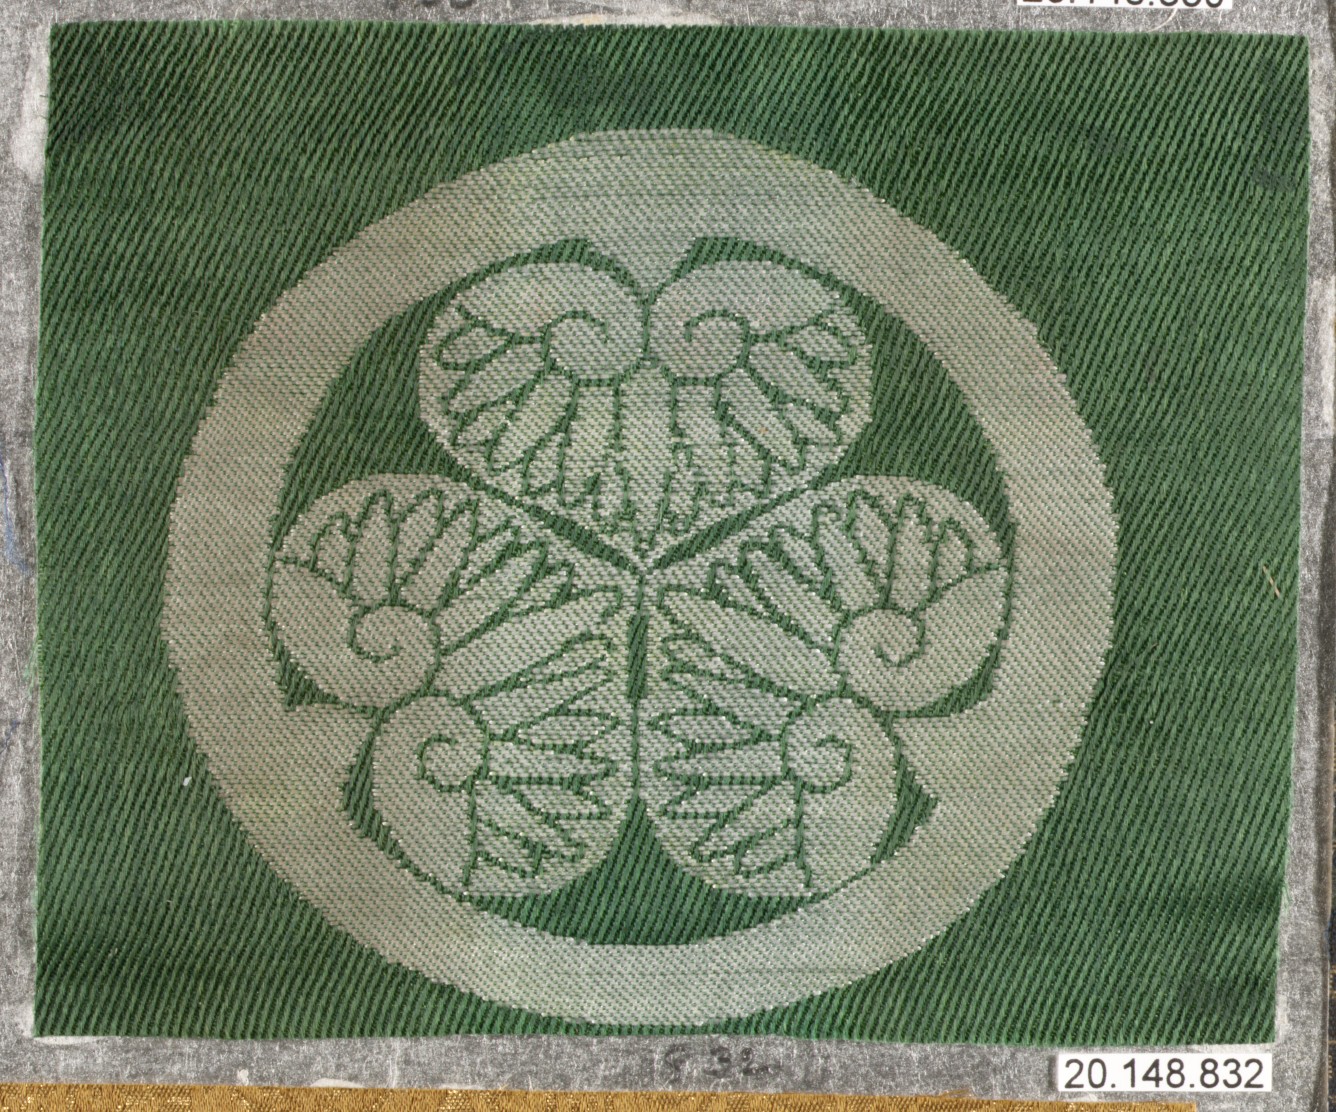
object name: piece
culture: japanese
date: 1701-1800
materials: silk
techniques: compound weave